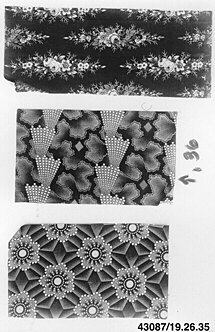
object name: sample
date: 1840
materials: cotton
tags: flowers,leaves